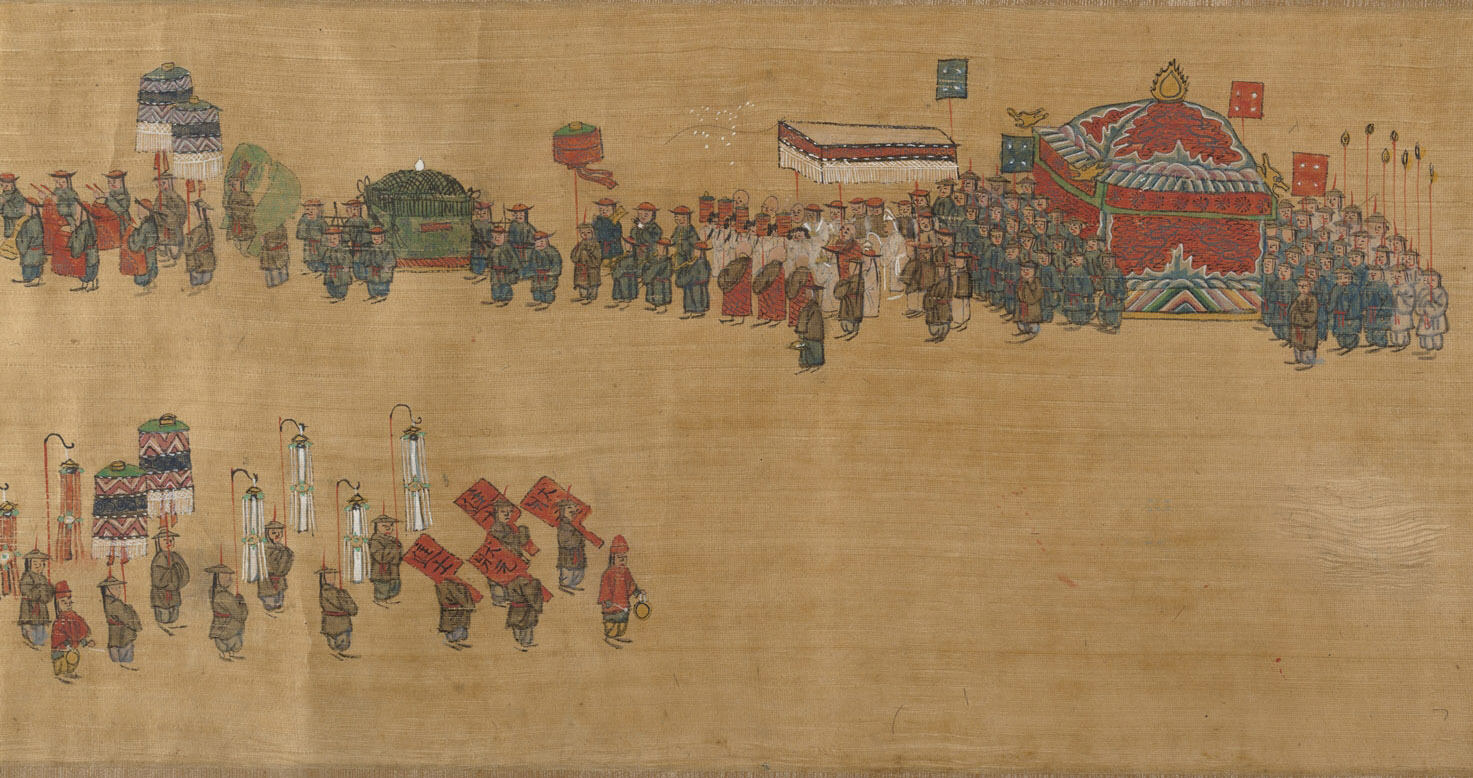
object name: handscroll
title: Procession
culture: chinese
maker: unidentified artist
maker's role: artist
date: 1867-1900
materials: ink, silk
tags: tents,men,processions